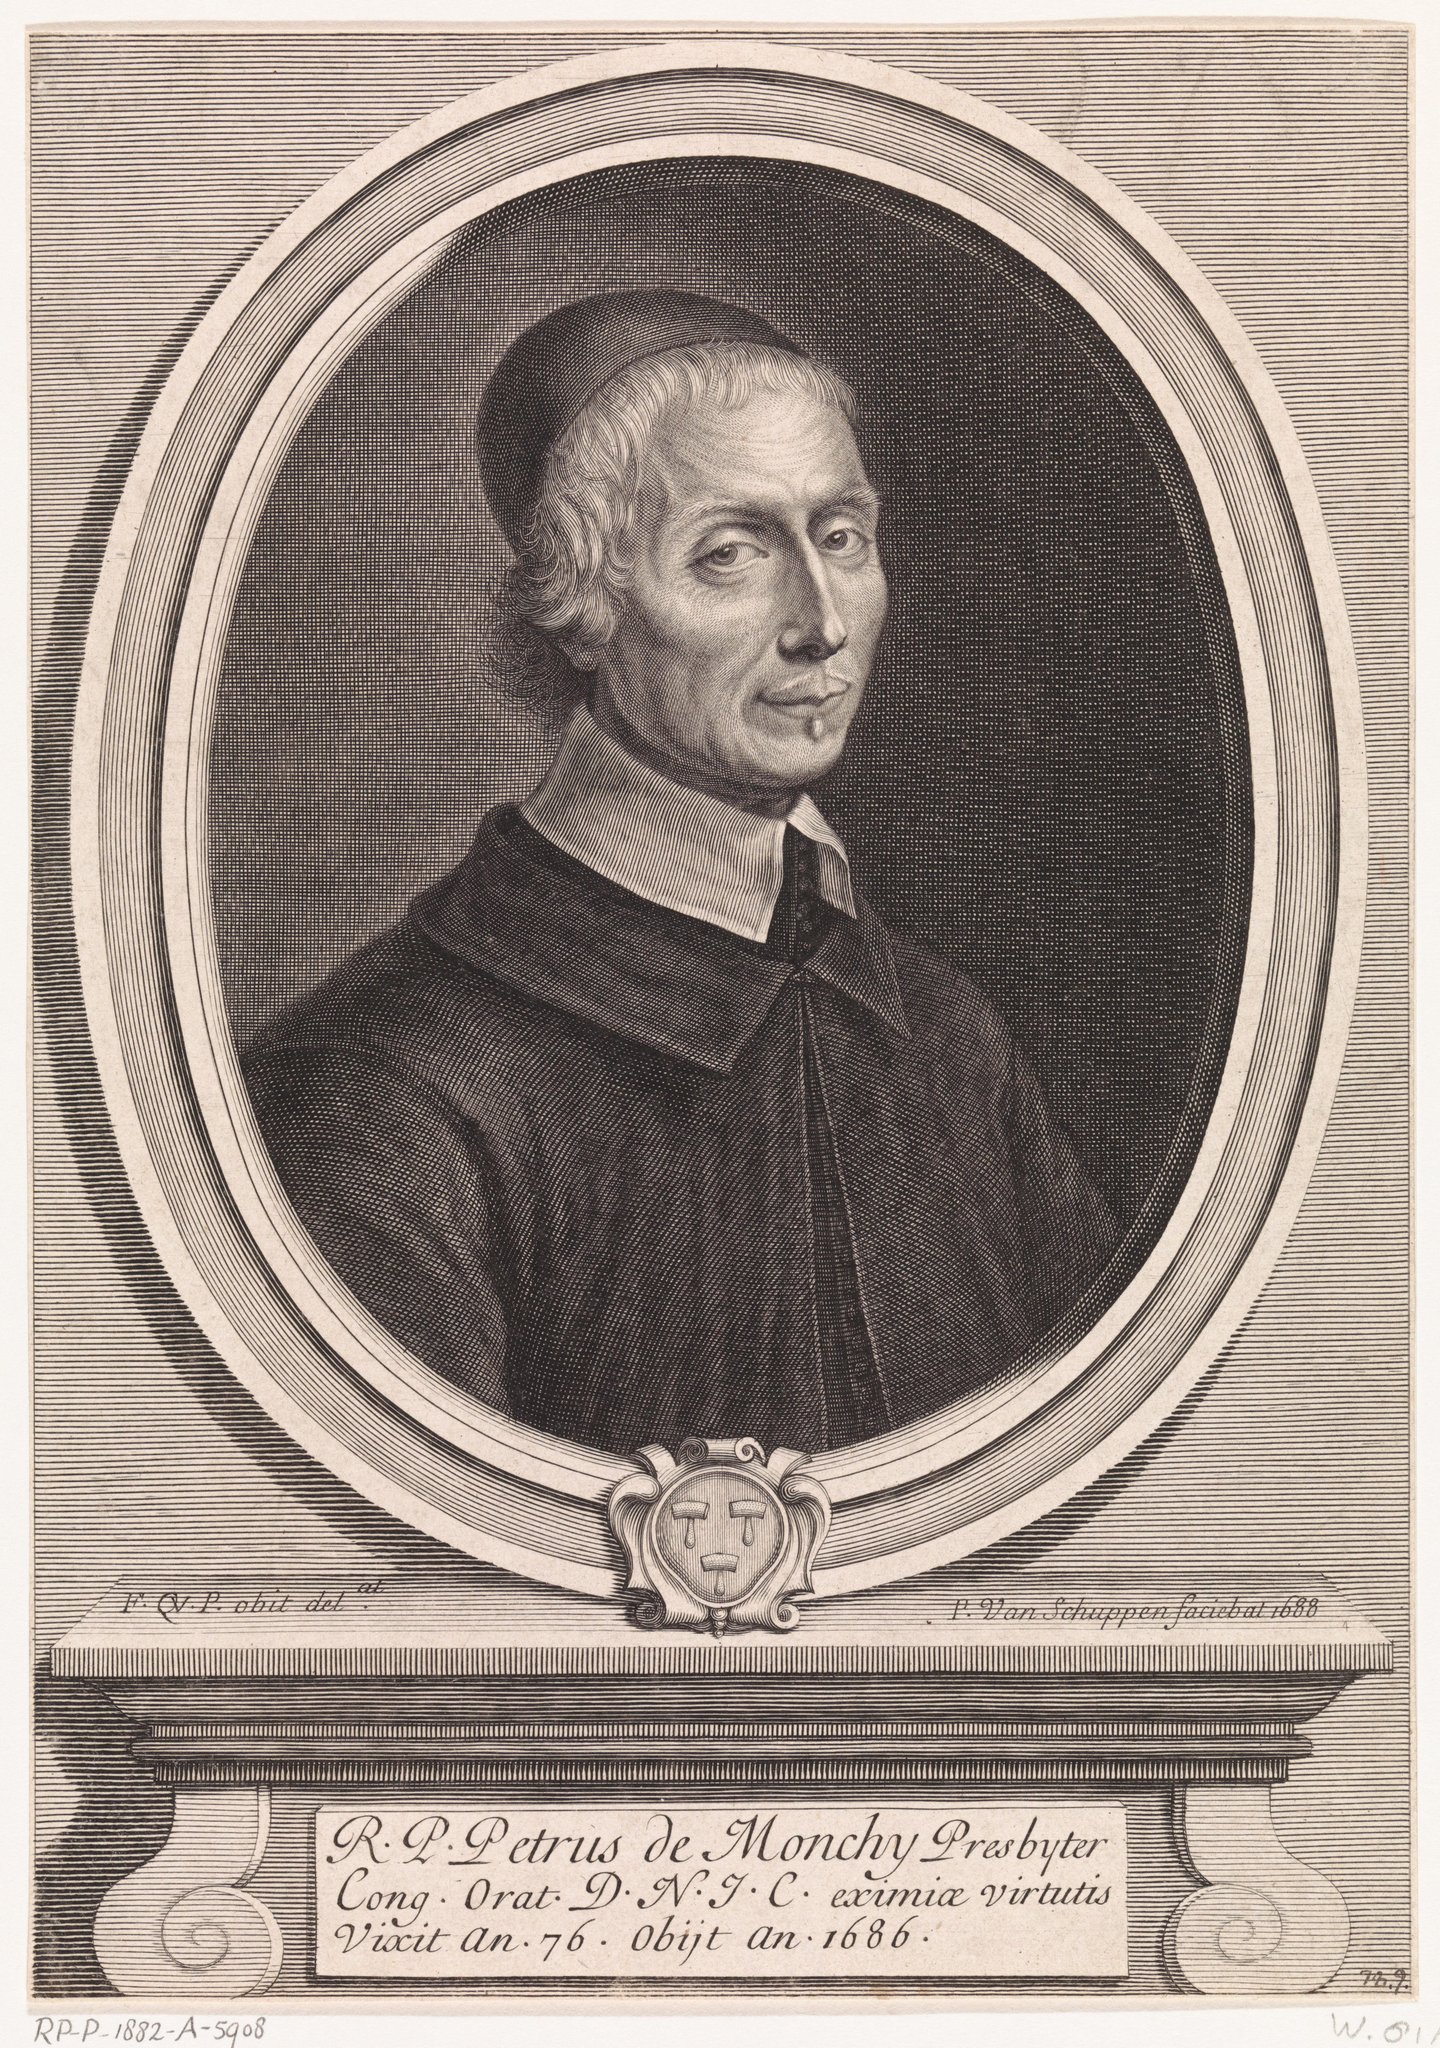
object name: print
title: Portret van de presbyteriaan Petrus de Monchy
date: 1604-1688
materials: paper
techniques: engraving, etching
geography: paris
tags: priest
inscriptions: collector's mark: Lugt 2228